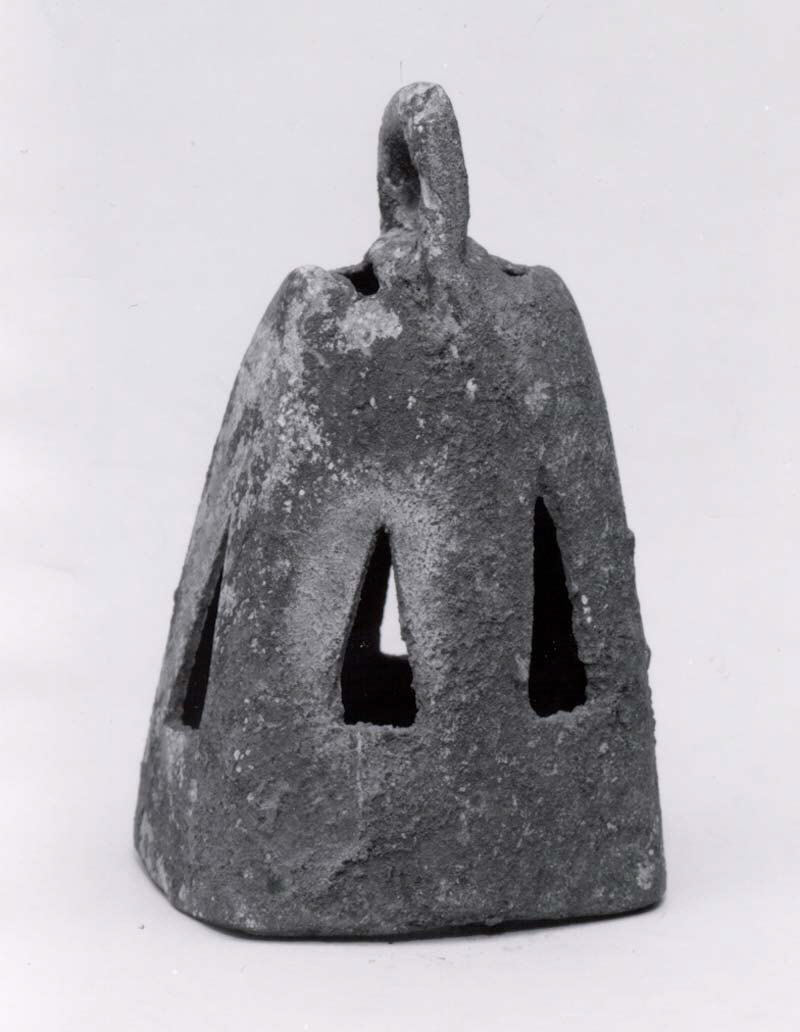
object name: bell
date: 1000-1 BCE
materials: bronze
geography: transcaucasia or iran